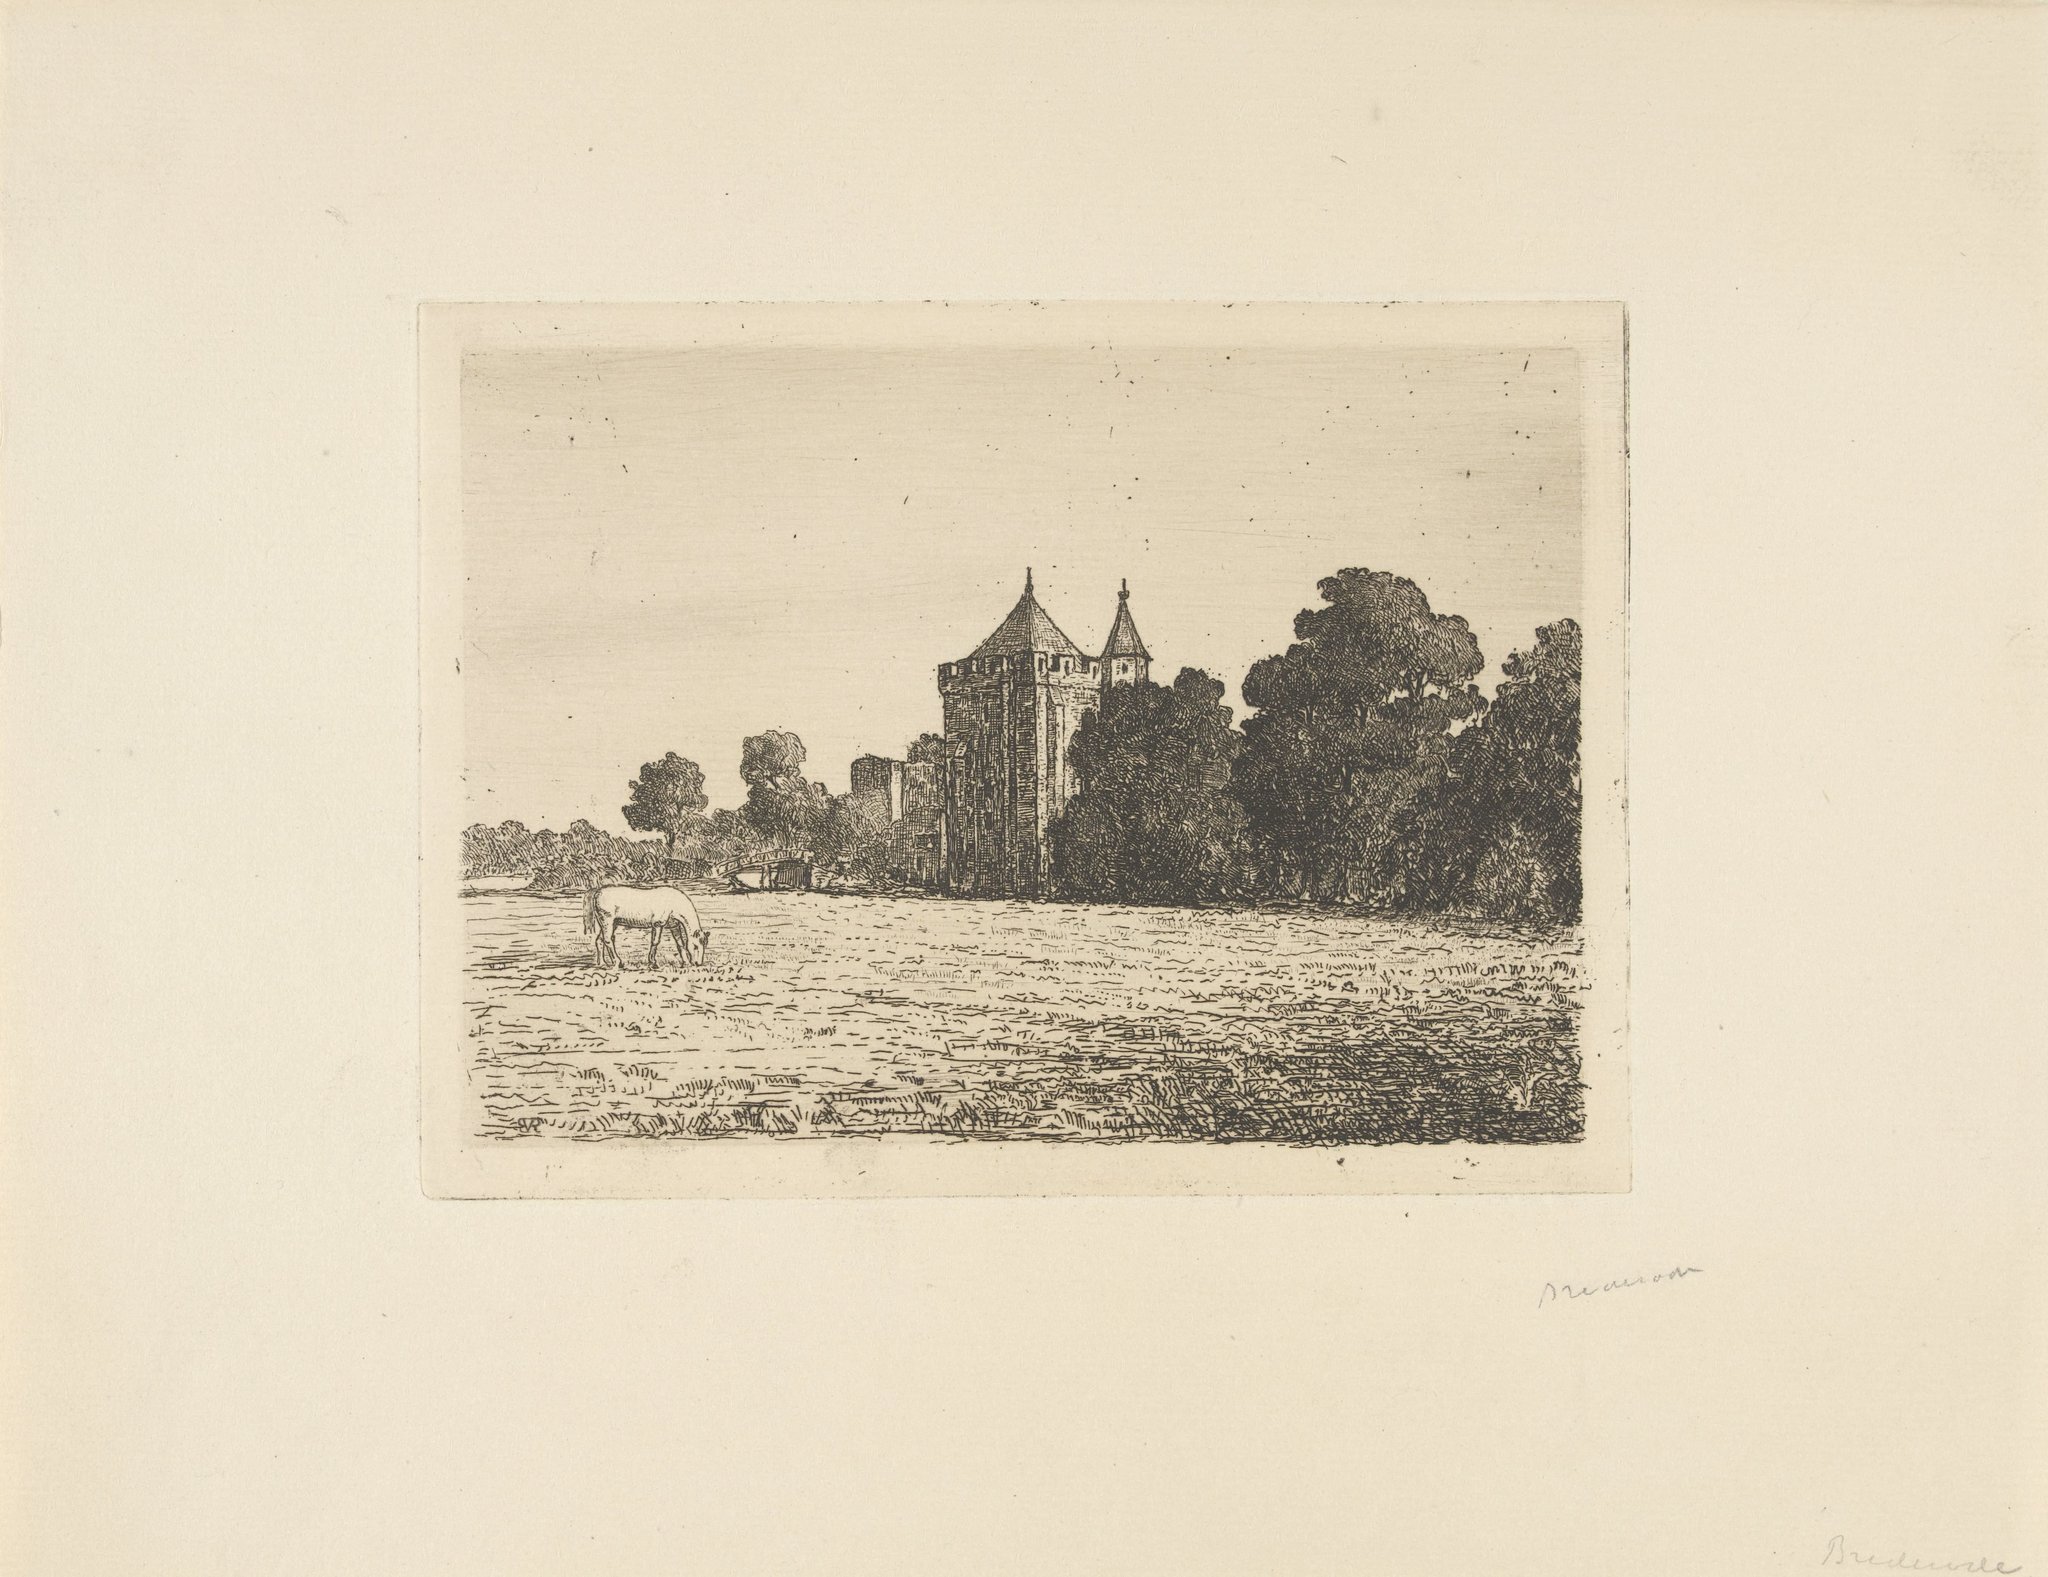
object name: print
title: Gezicht op kasteel Brederode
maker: jonkheer barthold willem floris van riemsdijk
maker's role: engineer, print maker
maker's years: 1850-1942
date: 1865-1918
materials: paper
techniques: etching, intaglio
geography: netherlands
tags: castle, horse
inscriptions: inscription: ‘Brederode’, collector's mark: Lugt 2228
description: Gezicht vanaf een weiland op kasteel Brederode te Santpoort. Op de voorgrond graast een paard.